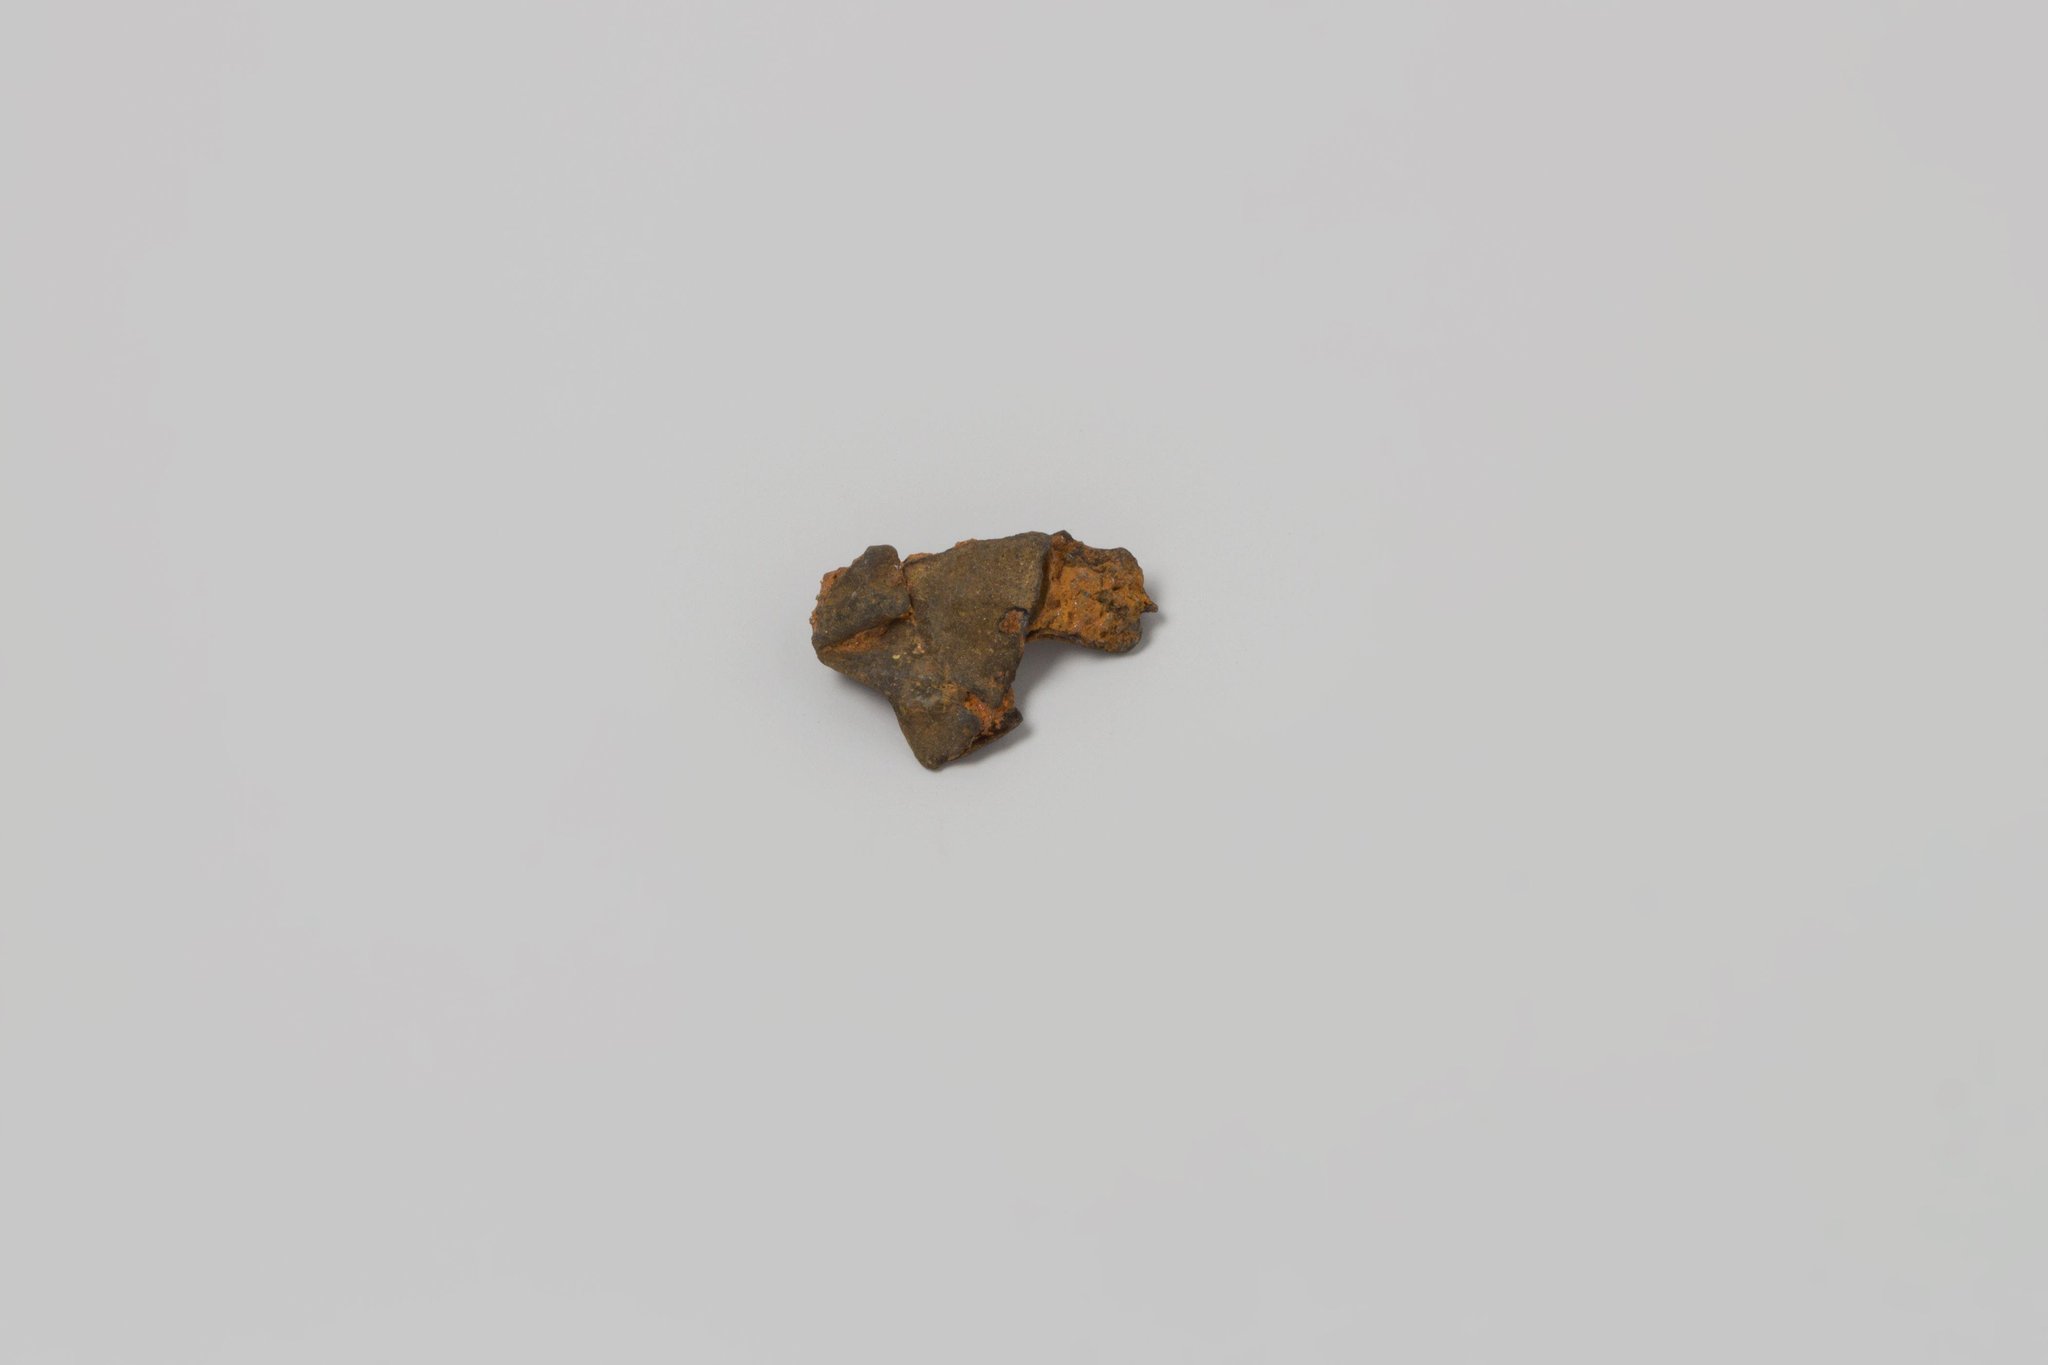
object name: fragment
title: Fragment uit het wrak van de Oost-Indiëvaarder Hollandia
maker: Anonymous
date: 1700-1743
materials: copper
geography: netherlands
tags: verenigde oostindische compagnie, hollandia (schip), annet